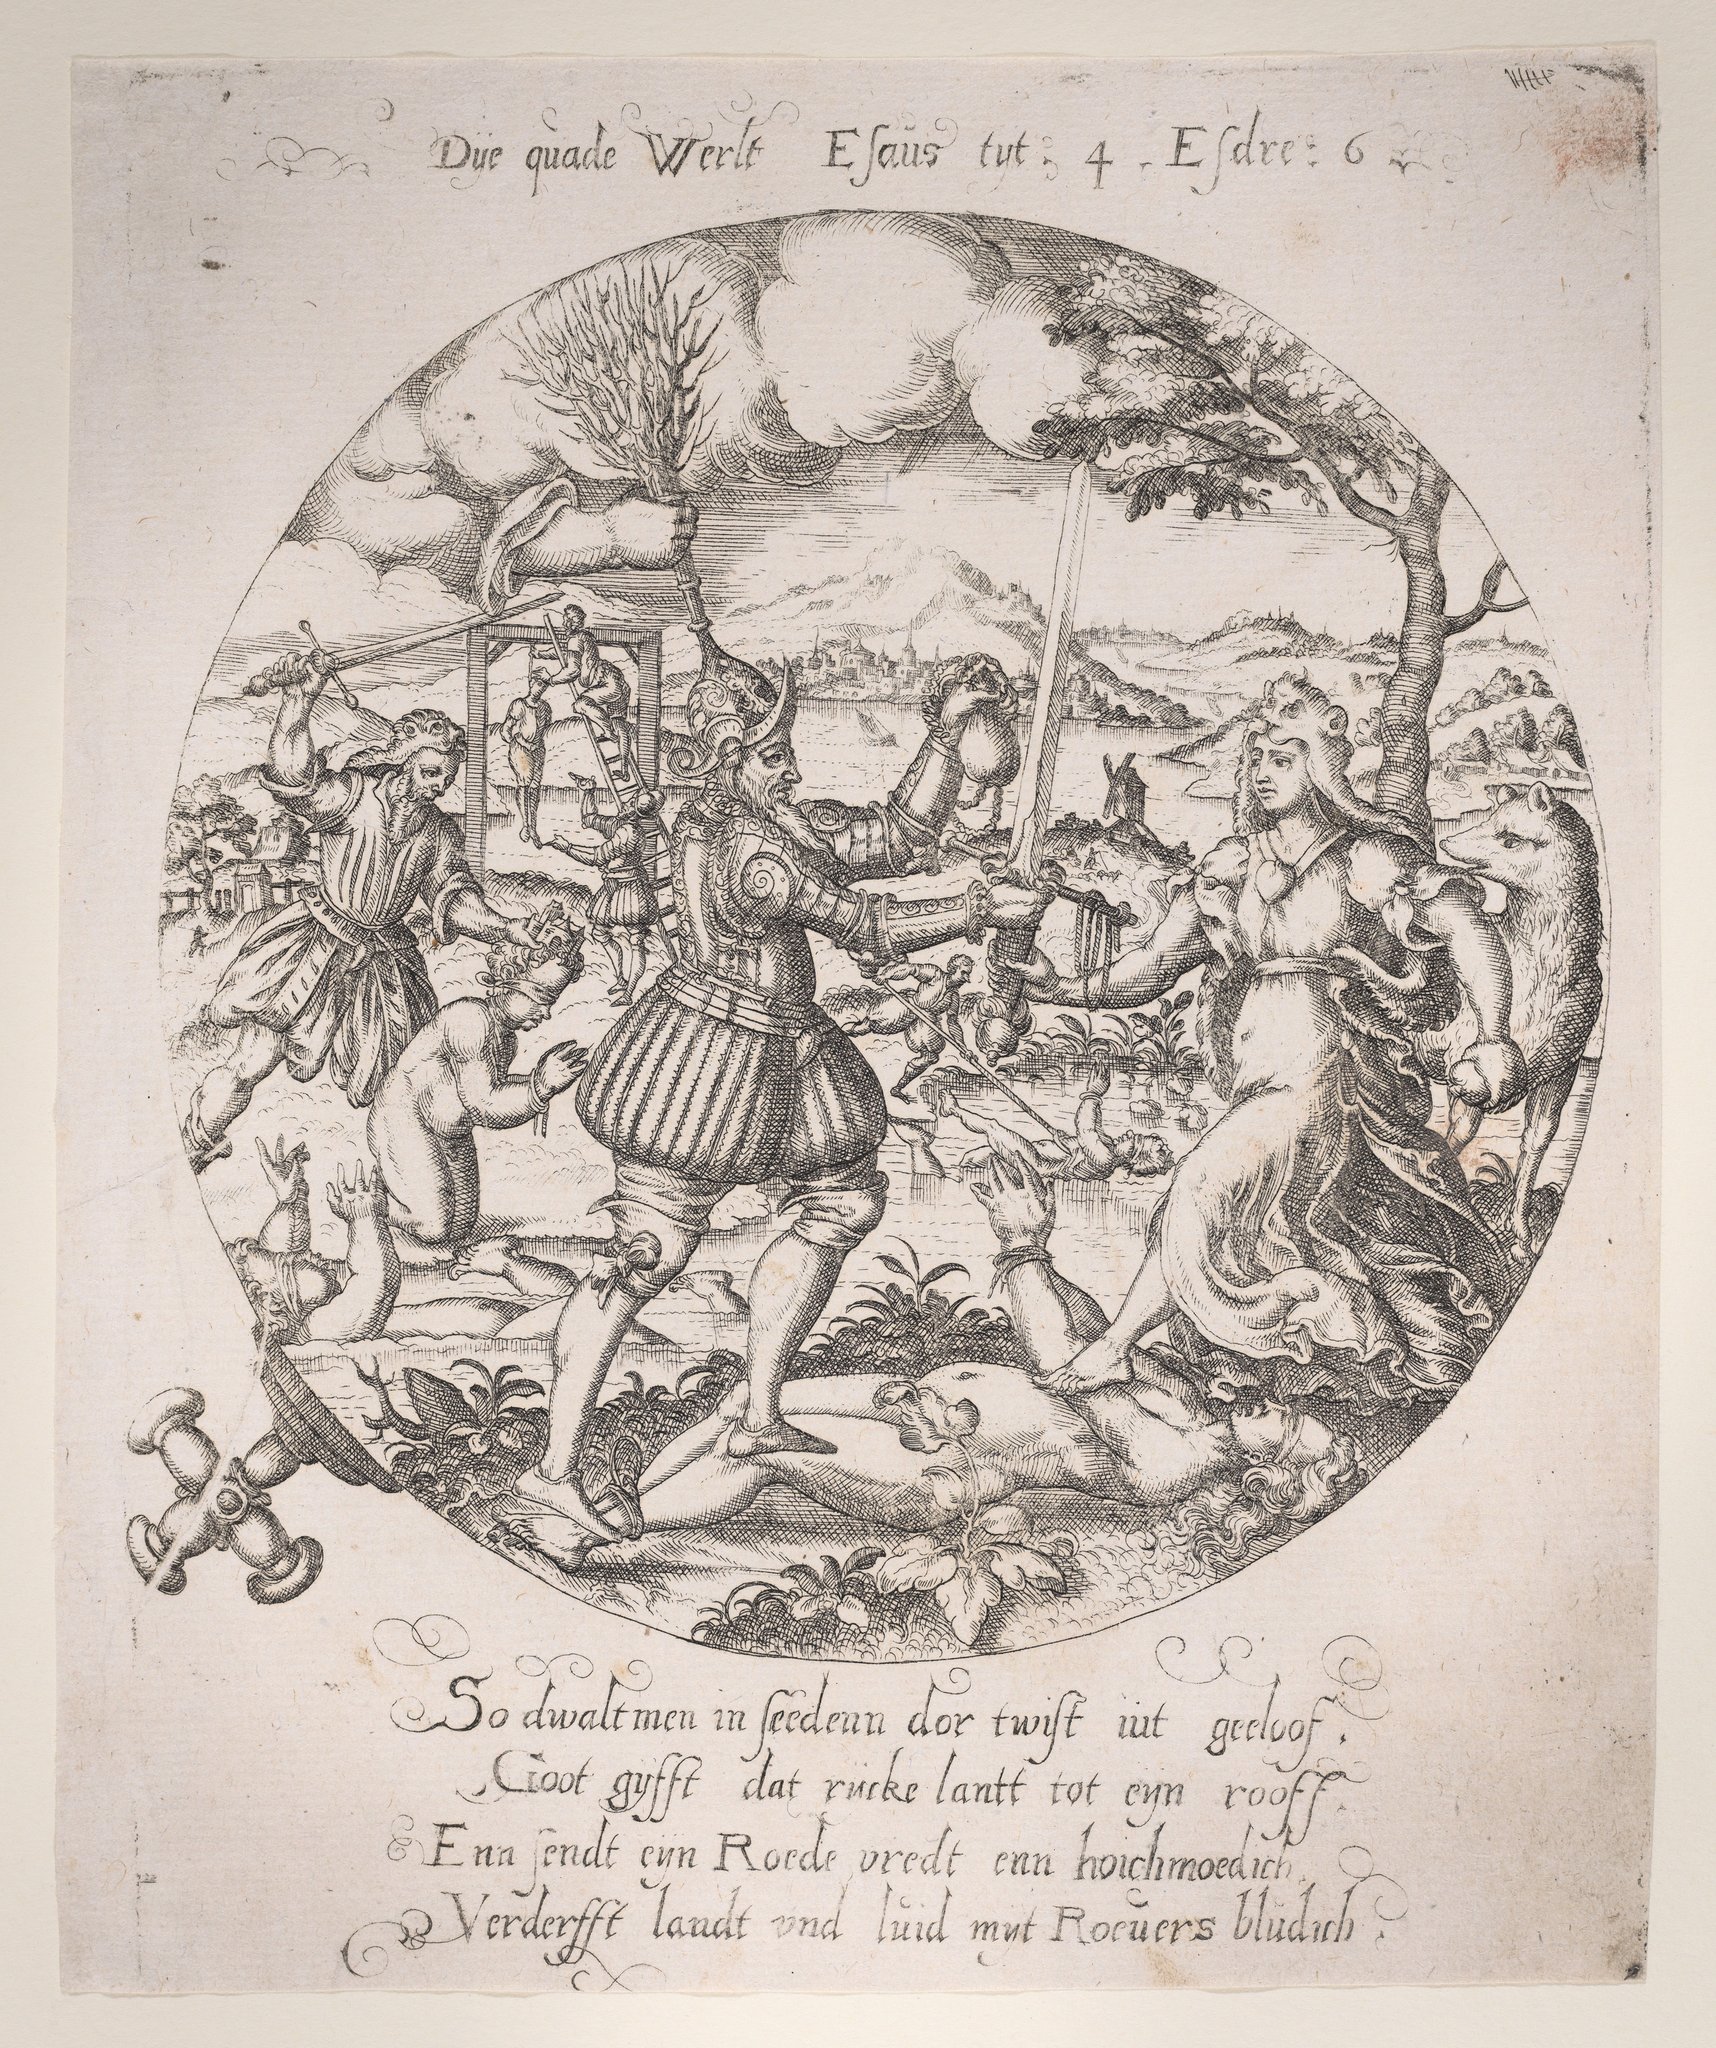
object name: print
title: The evil world / The time of Esau (2 Esdras 6:9), plate 3 from a series of Four Allegories of the Netherlands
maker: anonymous, netherlandish, 16th century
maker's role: artist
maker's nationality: netherlandish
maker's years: 1500-1600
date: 1570-1572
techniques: etching